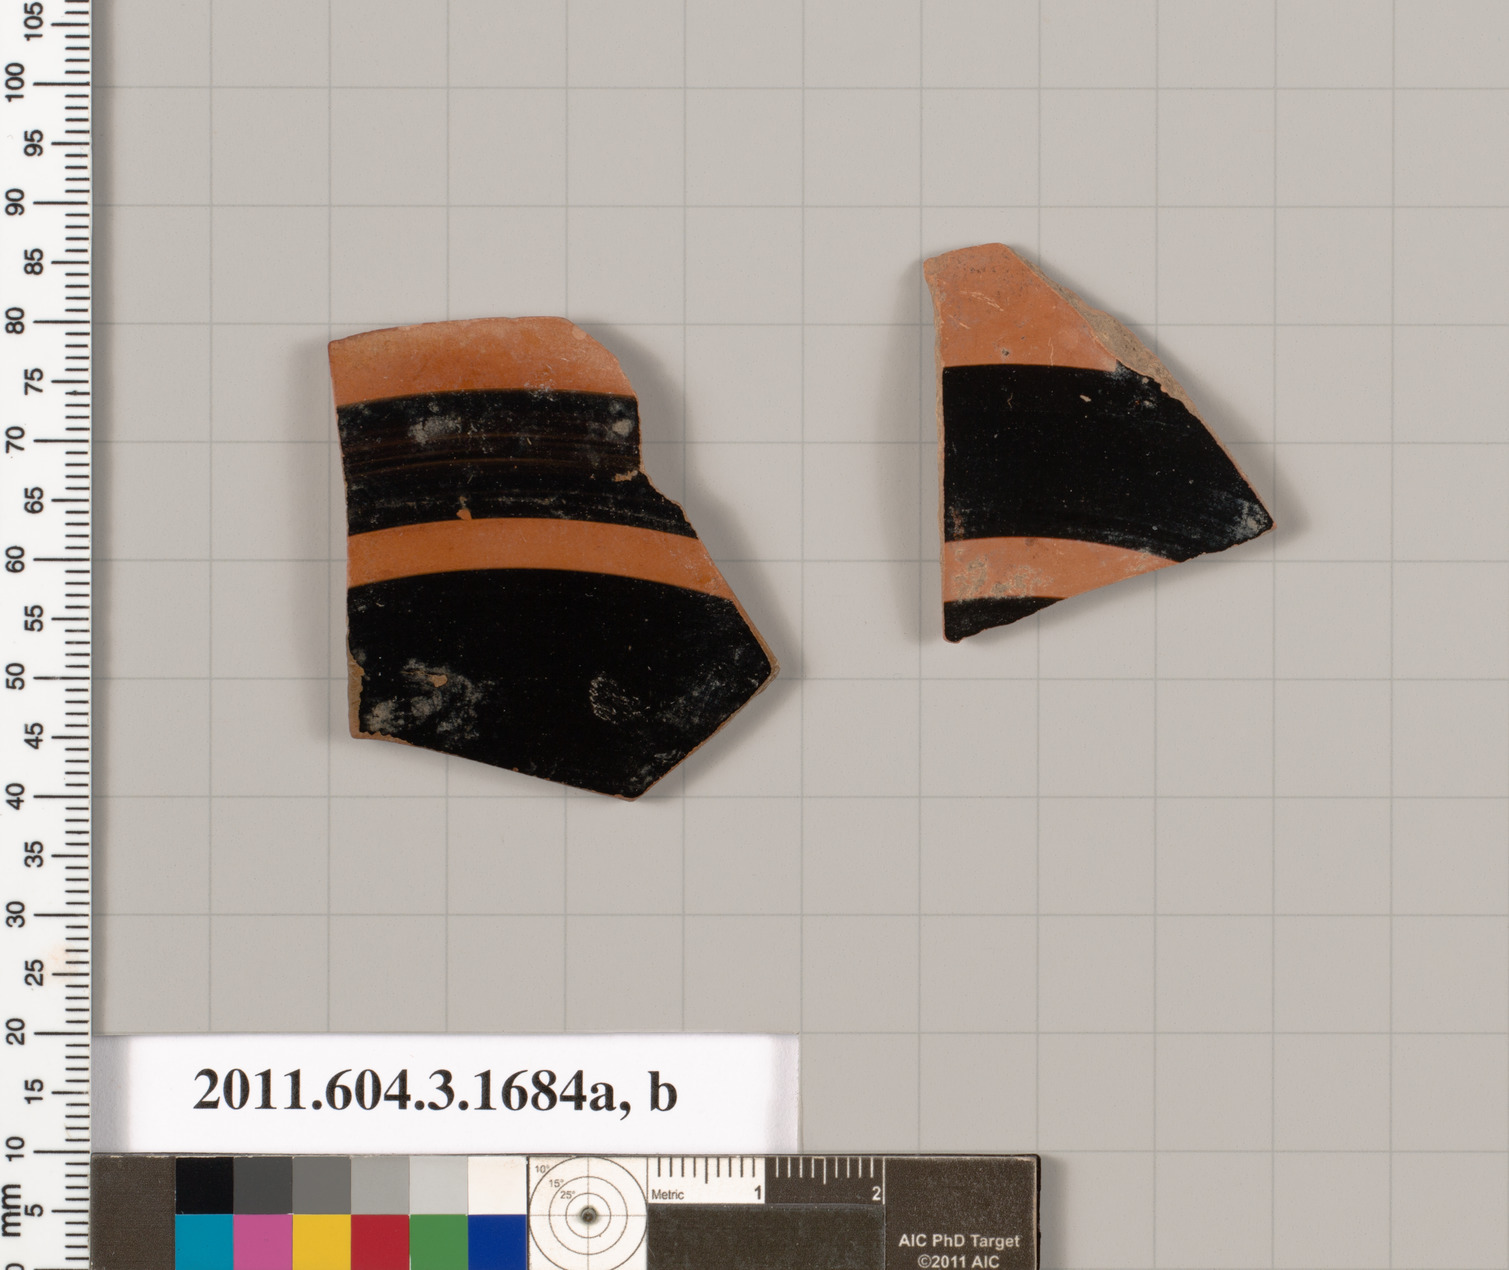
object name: kylix fragment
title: Terracotta fragments of kylikes: Band or lip cups (drinking cups)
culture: greek, attic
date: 550-526 BCE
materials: terracotta